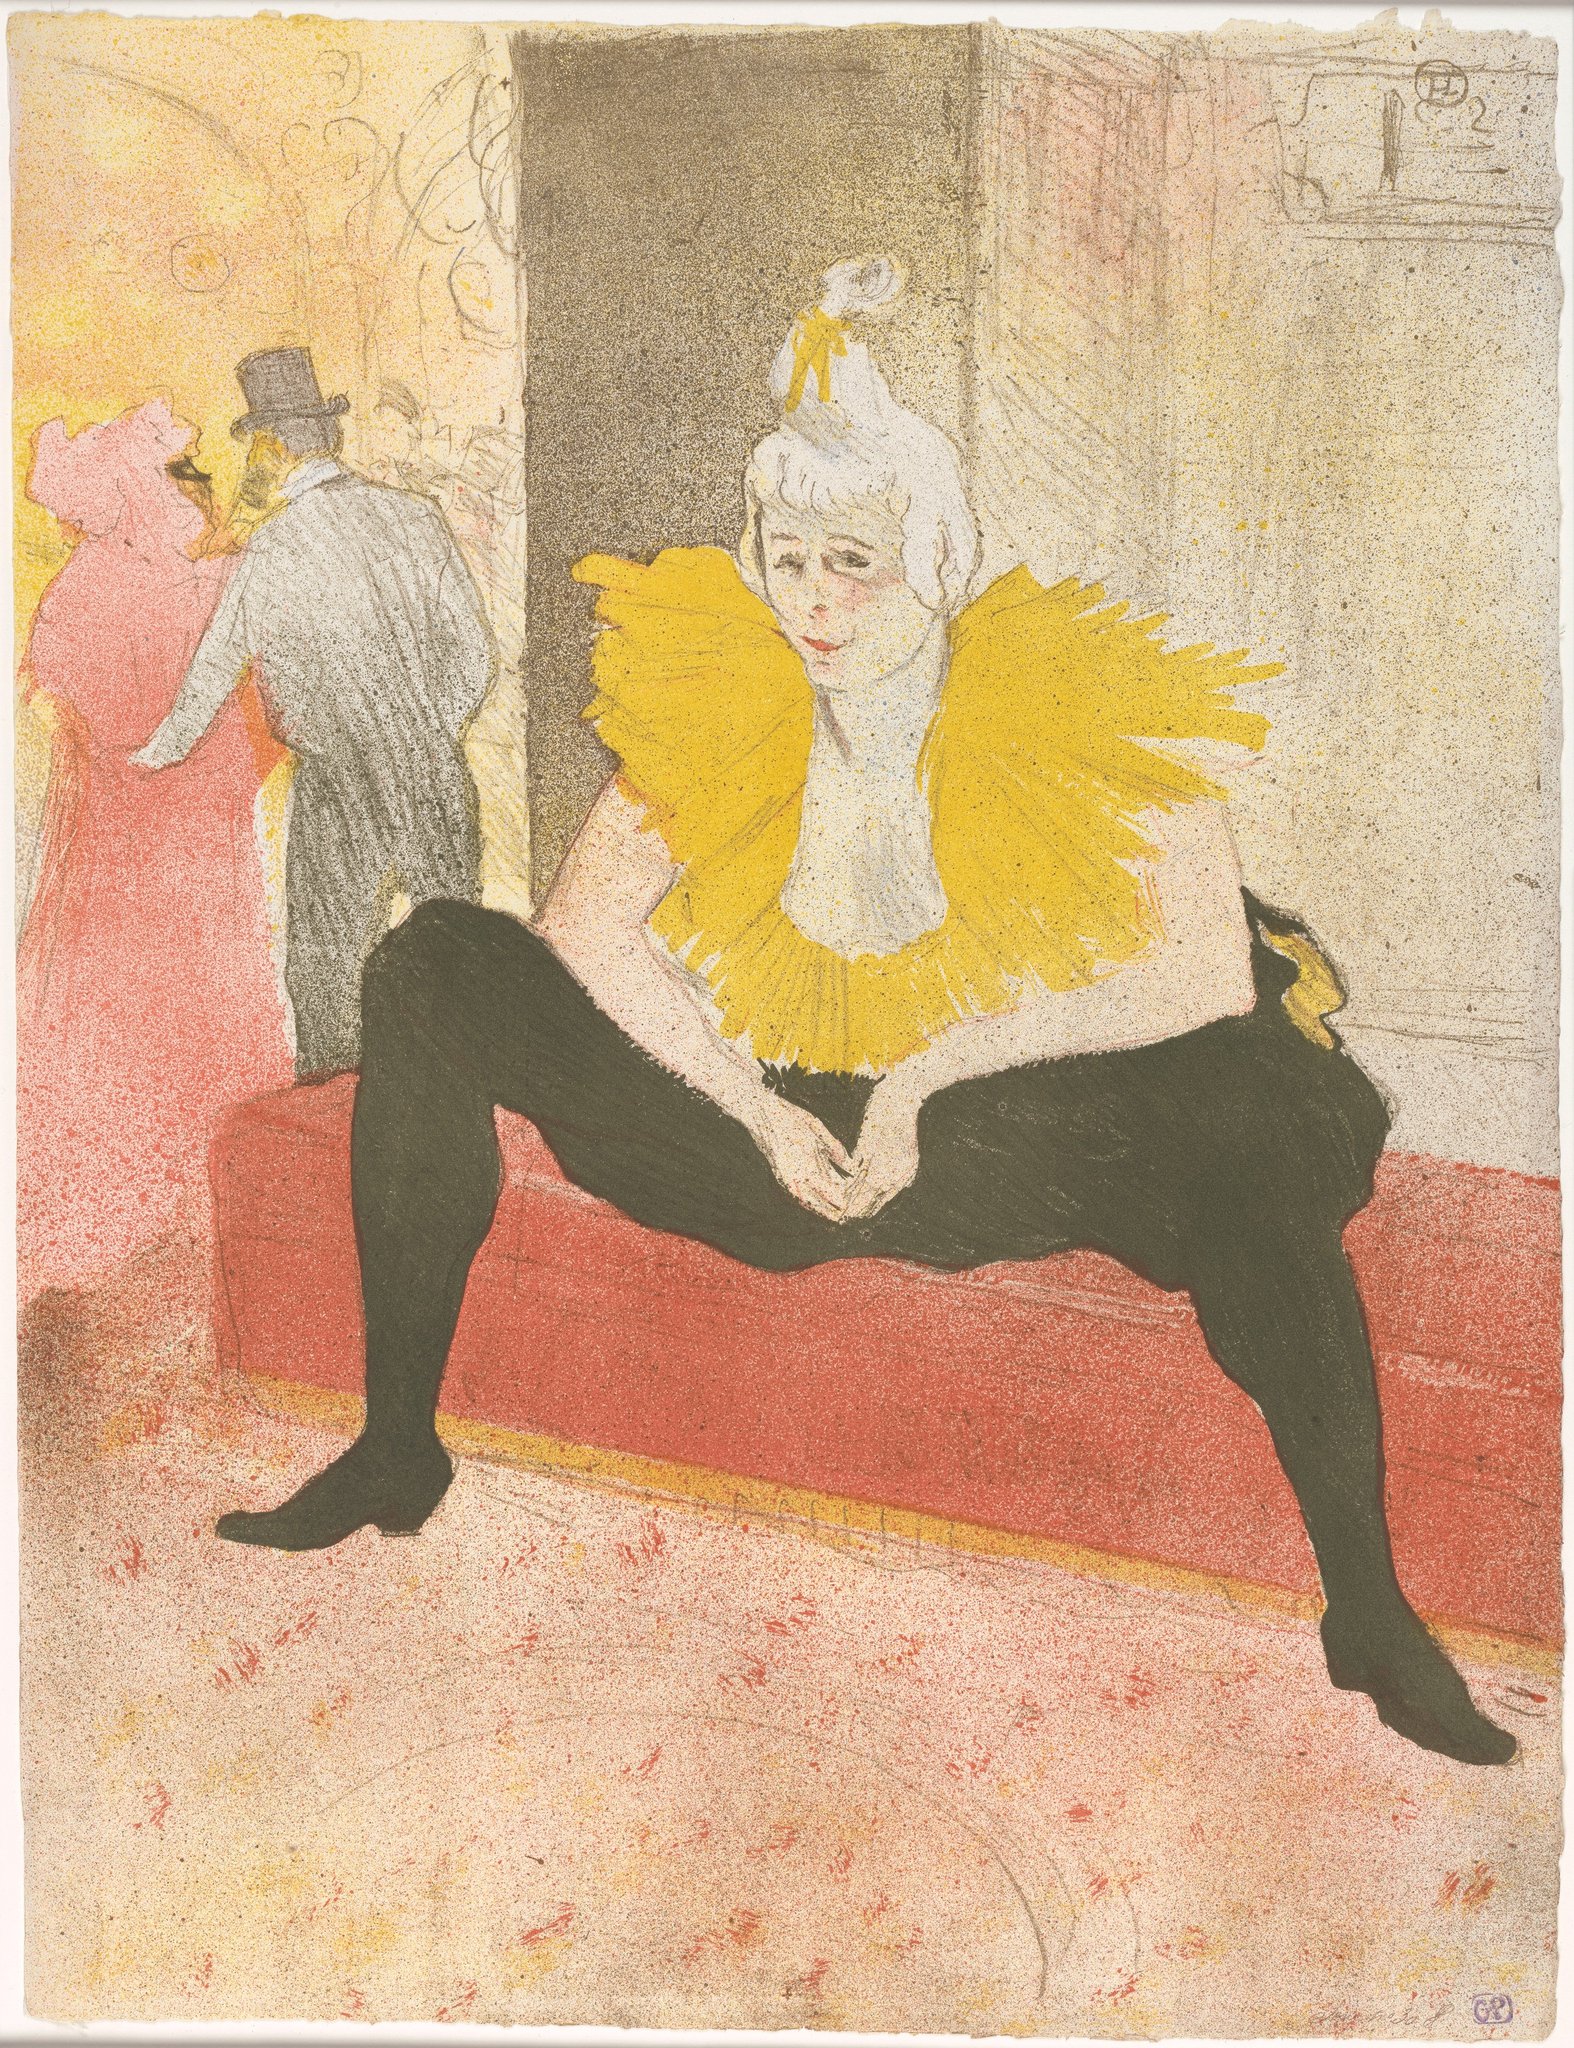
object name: print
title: The Seated Clowness (Mademoiselle Cha-u-ka-o), from "Elles"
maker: henri de toulouse-lautrec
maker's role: artist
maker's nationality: french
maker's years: 1864-1901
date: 1896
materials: crayon, paper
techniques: brush, lithograph, printing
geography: france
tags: women,clowns